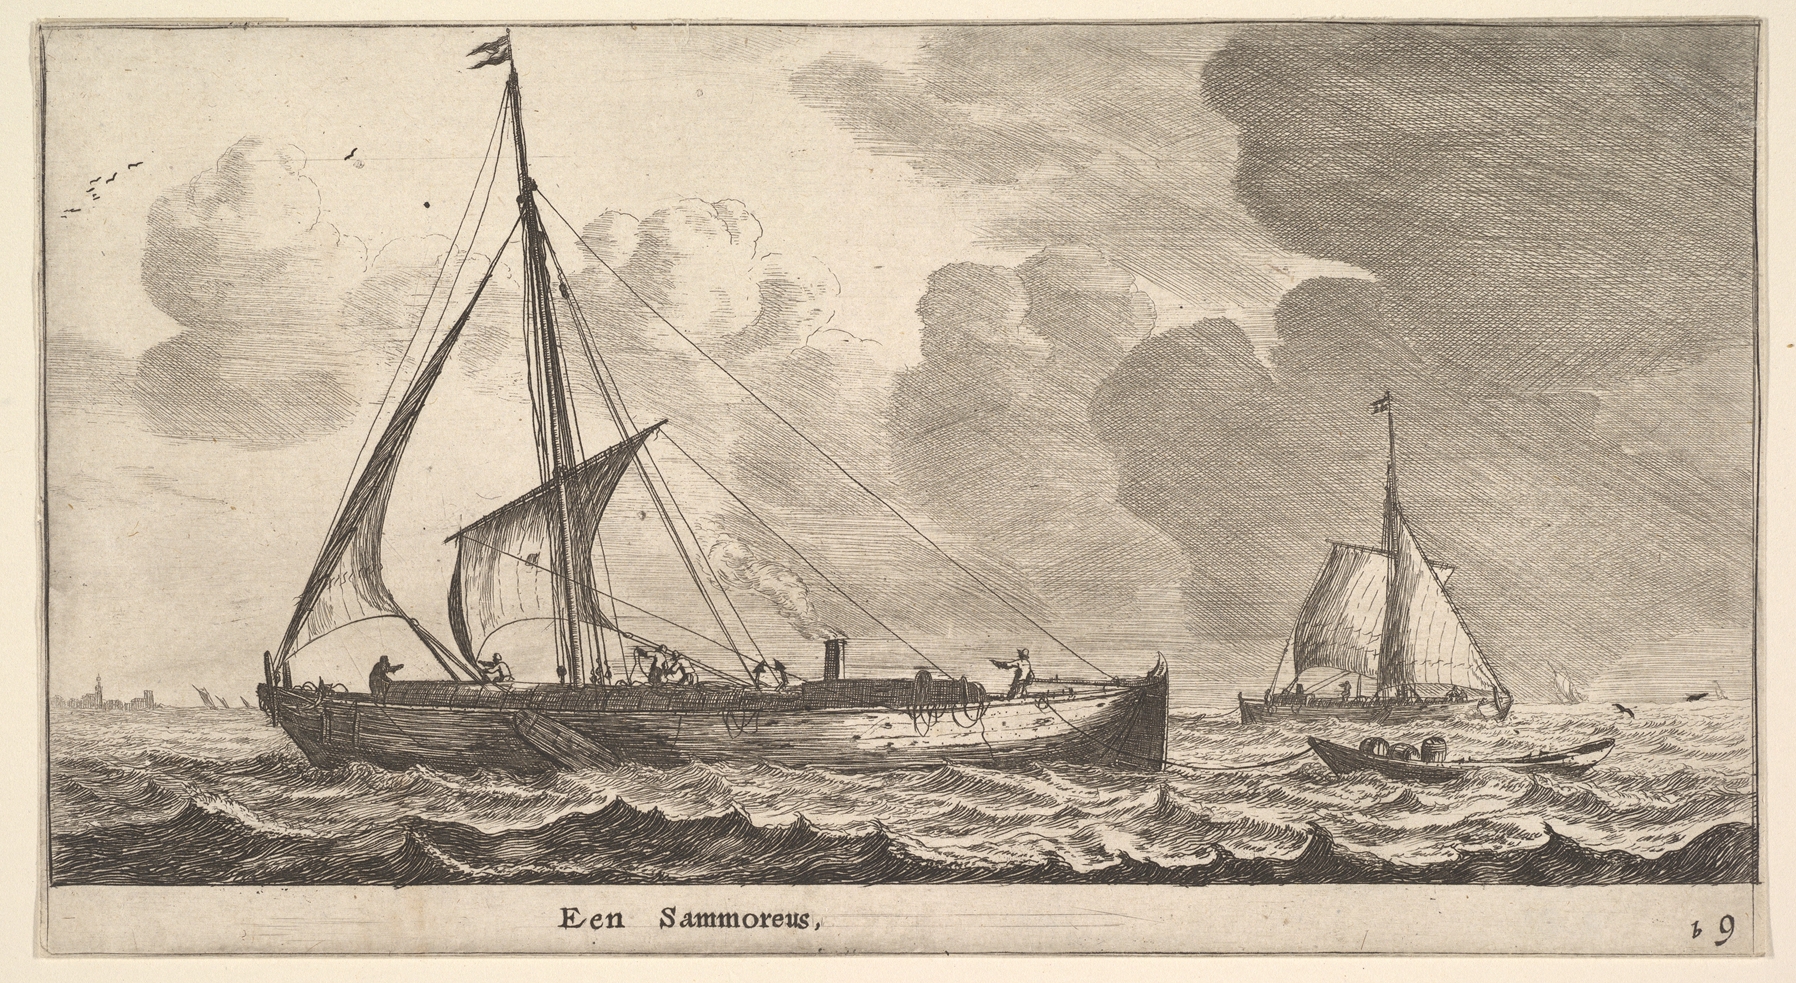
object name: print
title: Een Samoureus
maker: reinier nooms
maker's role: artist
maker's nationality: dutch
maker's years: 1623-1664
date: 1601-1700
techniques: etching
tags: boats